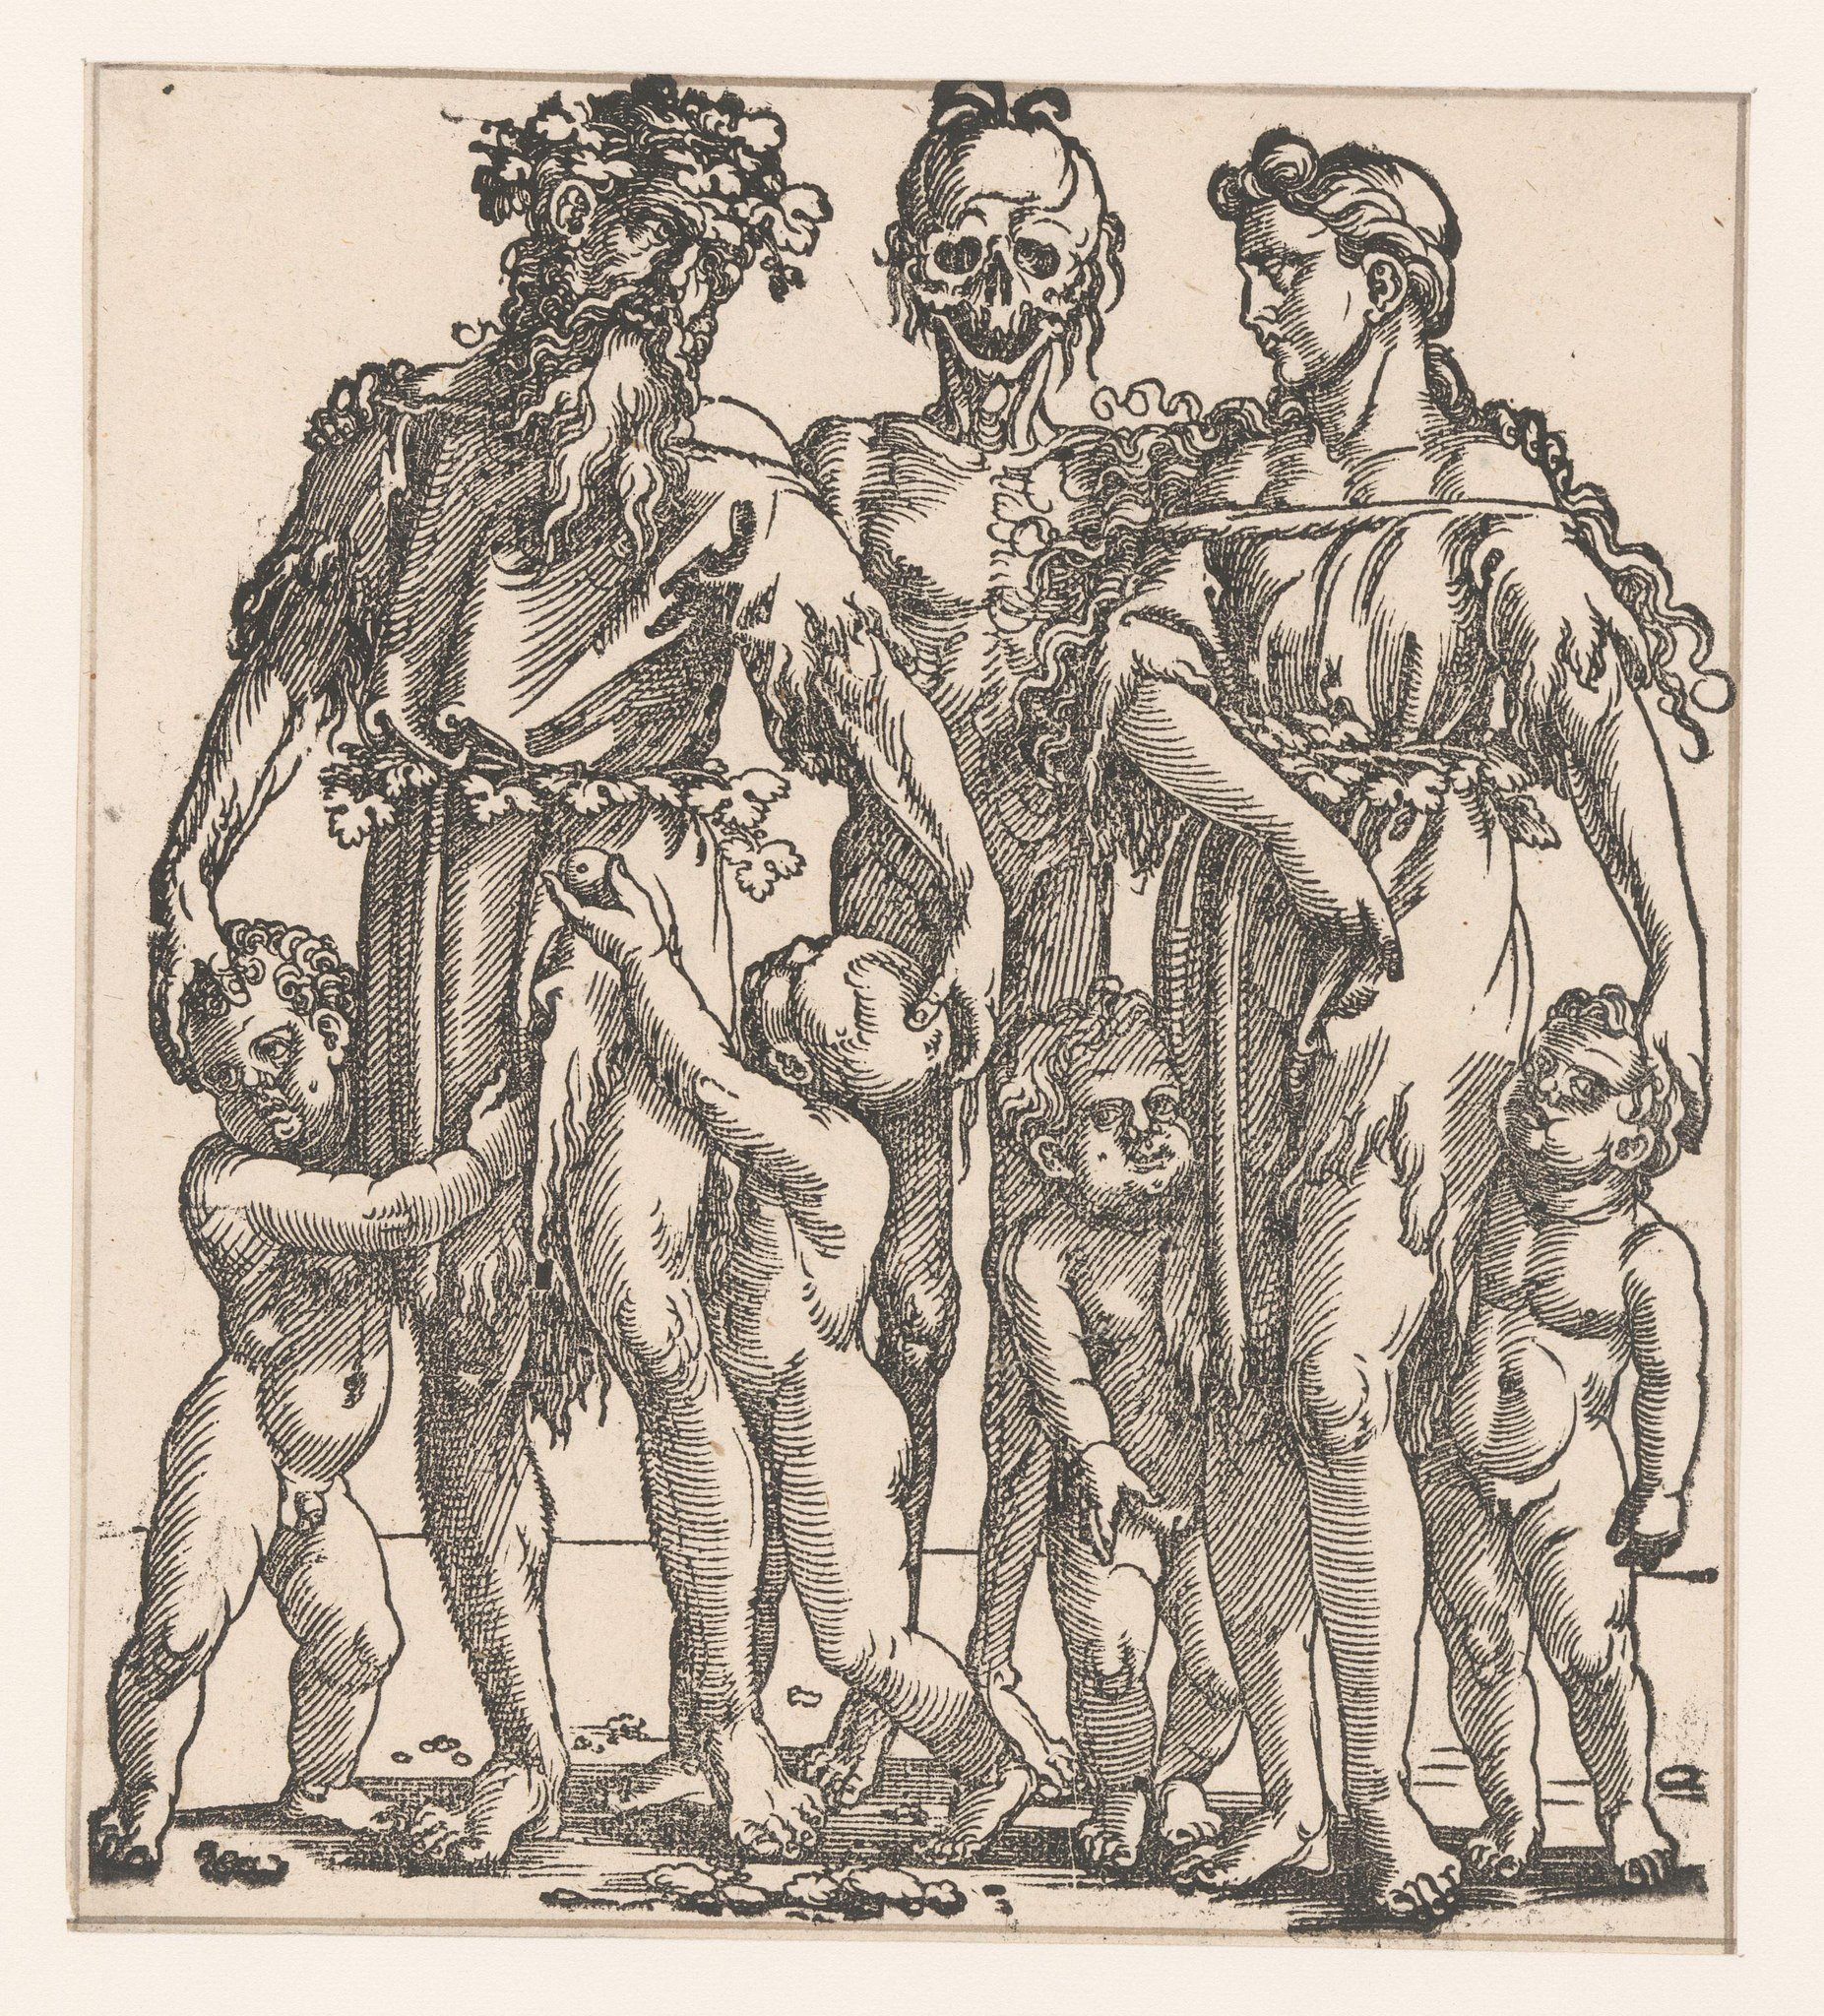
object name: print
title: Adam met Eva en kinderen en met de dood als skelet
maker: Anonymous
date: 1530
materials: paper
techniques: woodcut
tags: personifications of death; 'morte' (ripa), adam and eve (not in biblical context)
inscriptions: collector's mark: Lugt 240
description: Onderdeel van een serie van tien houtsnedes met de patriarchen.